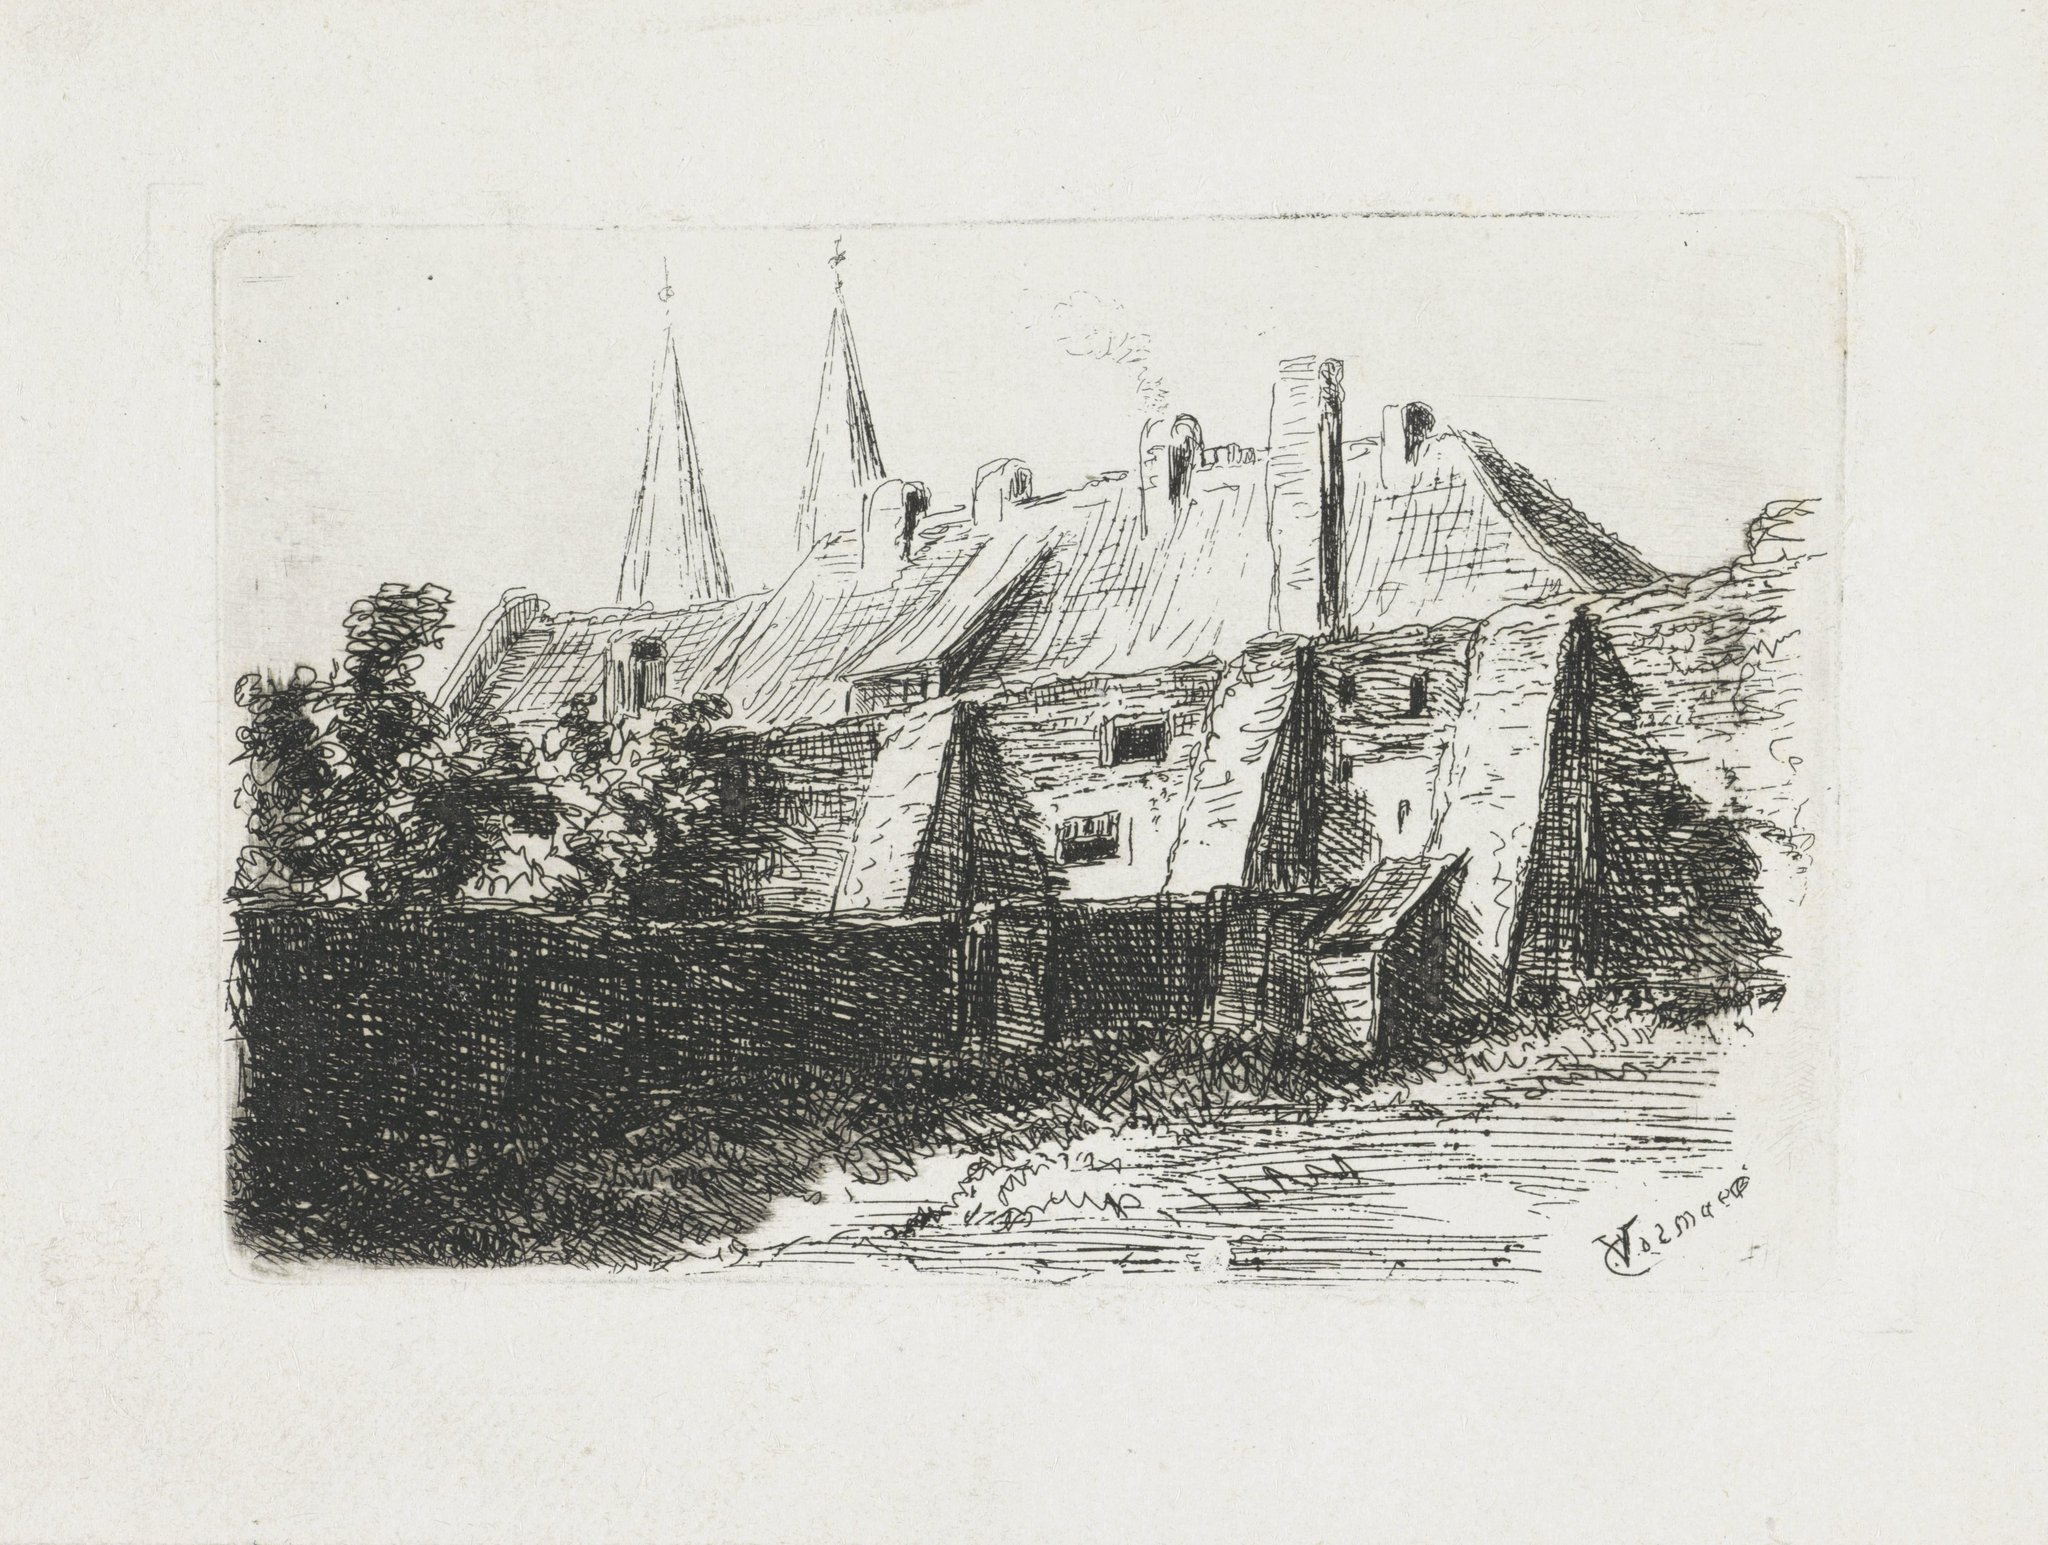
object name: print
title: Huizen bij een stadsmuur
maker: carel vosmaer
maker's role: draughtsman, print maker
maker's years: 1826-1888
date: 1836-1888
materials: paper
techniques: etching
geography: netherlands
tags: roof (of house or building), village-walls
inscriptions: collector's mark: Lugt 2760, collector's mark: Lugt 2228